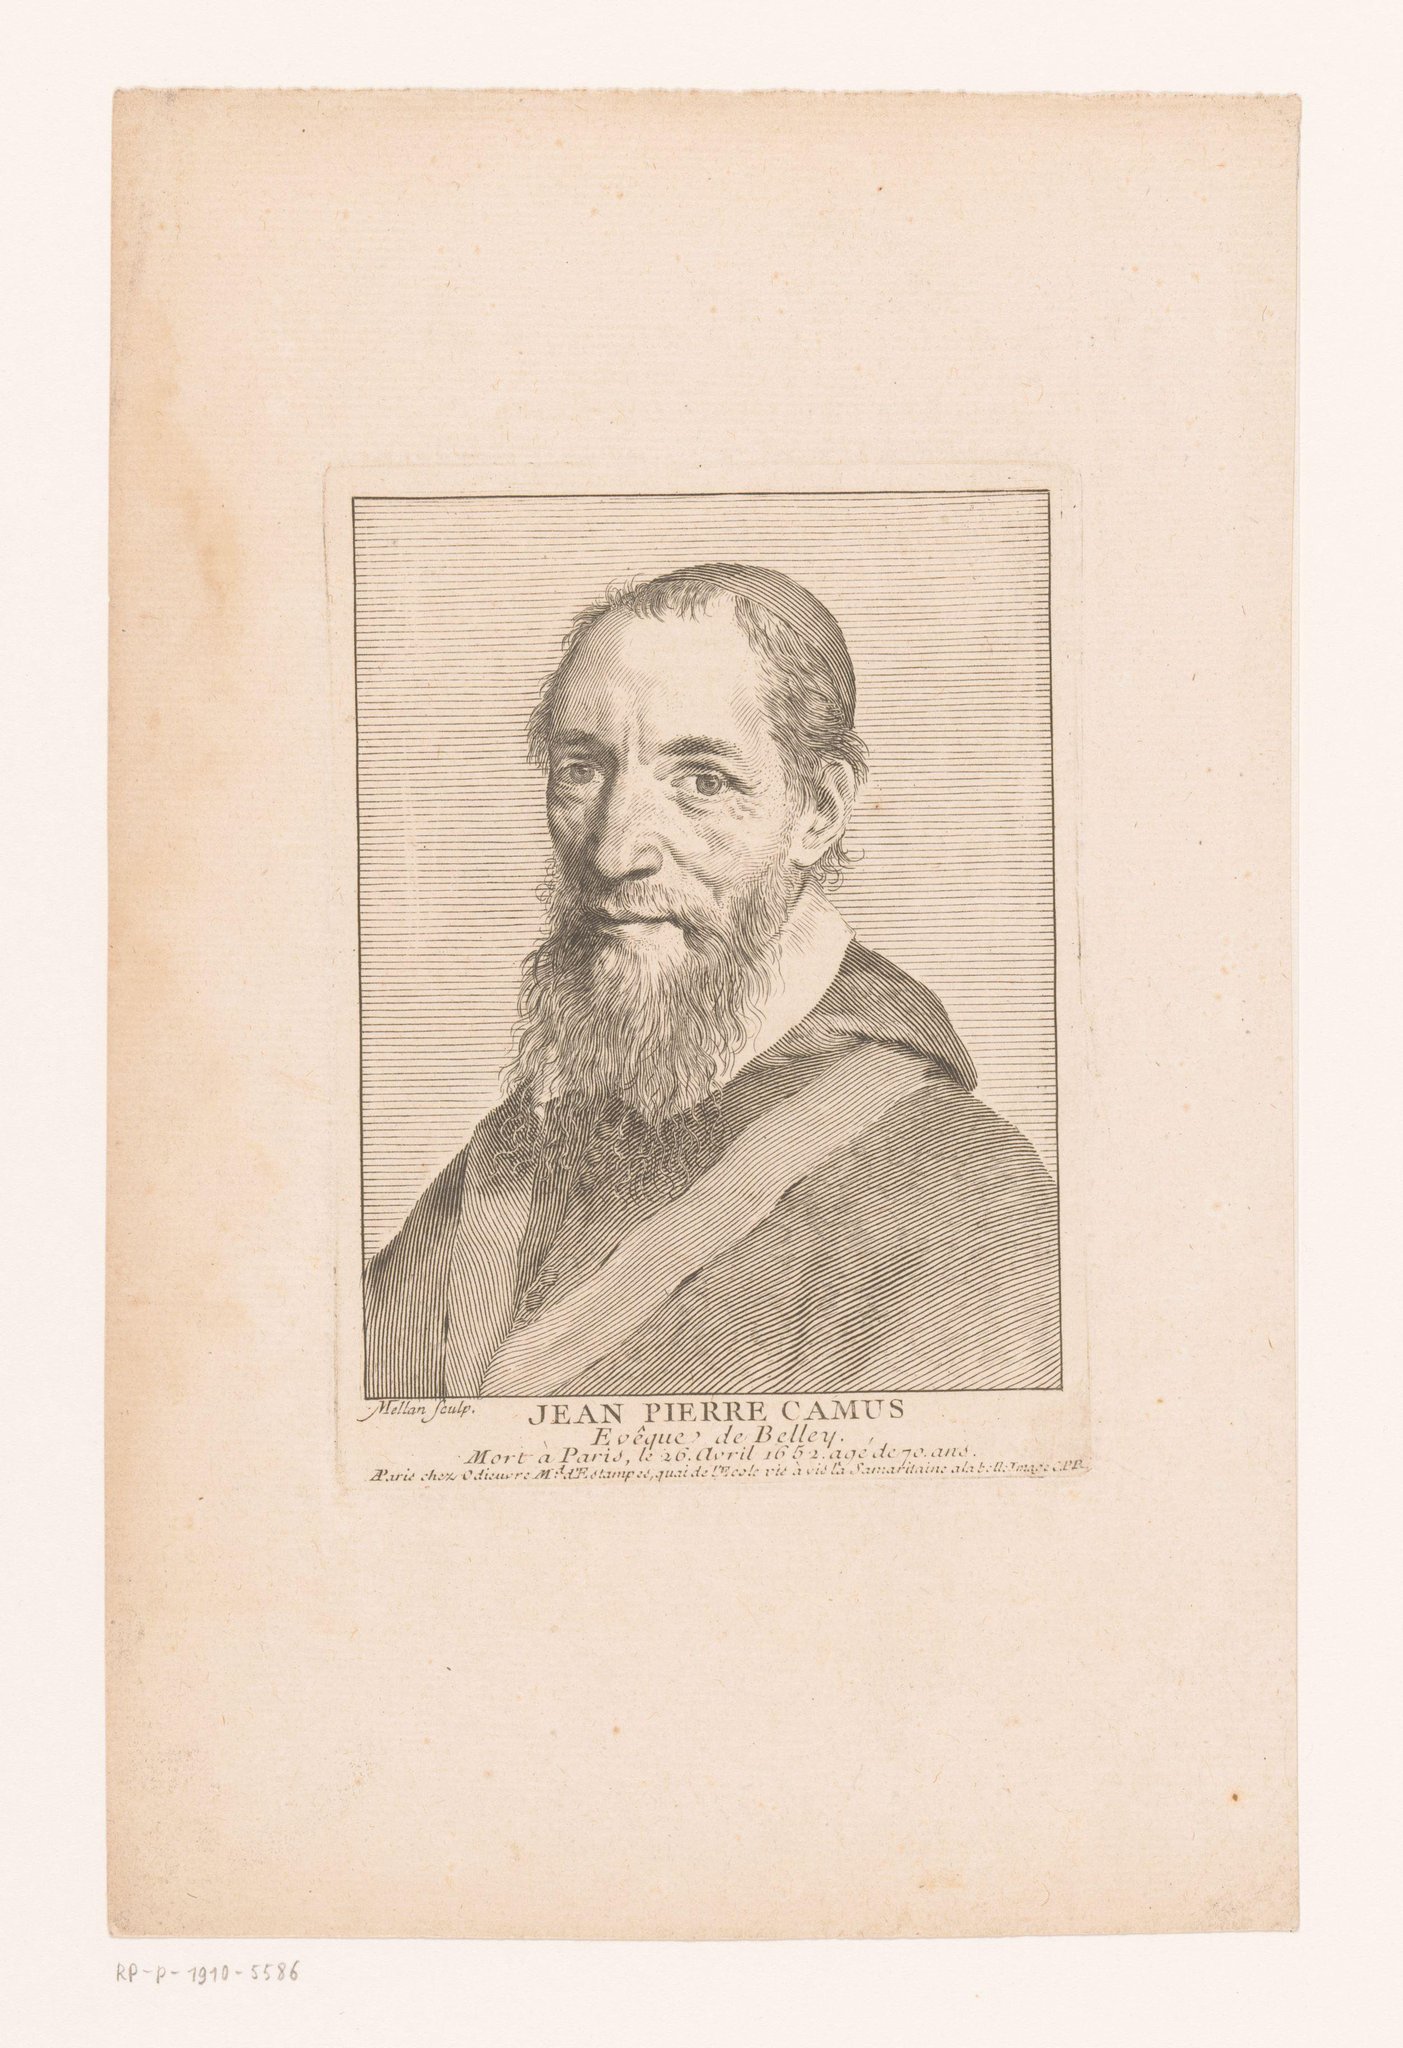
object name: print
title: Portret van Jean-Pierre Camus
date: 1652-1688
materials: paper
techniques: engraving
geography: paris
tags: paris, historical persons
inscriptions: collector's mark: Lugt 2228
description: Prent uit: Dreux du Radier, Jean-François. L'Europe illustré, contenant l'histoire abregée des souverains, des princes, des prélats, des ministres, (...) en Europe: dans le XVe. siècle compris, jusqu'à présent. Parijs: Michel Odieuvre en Jean-Luc Nyon, 1755-1765, dl. 5.